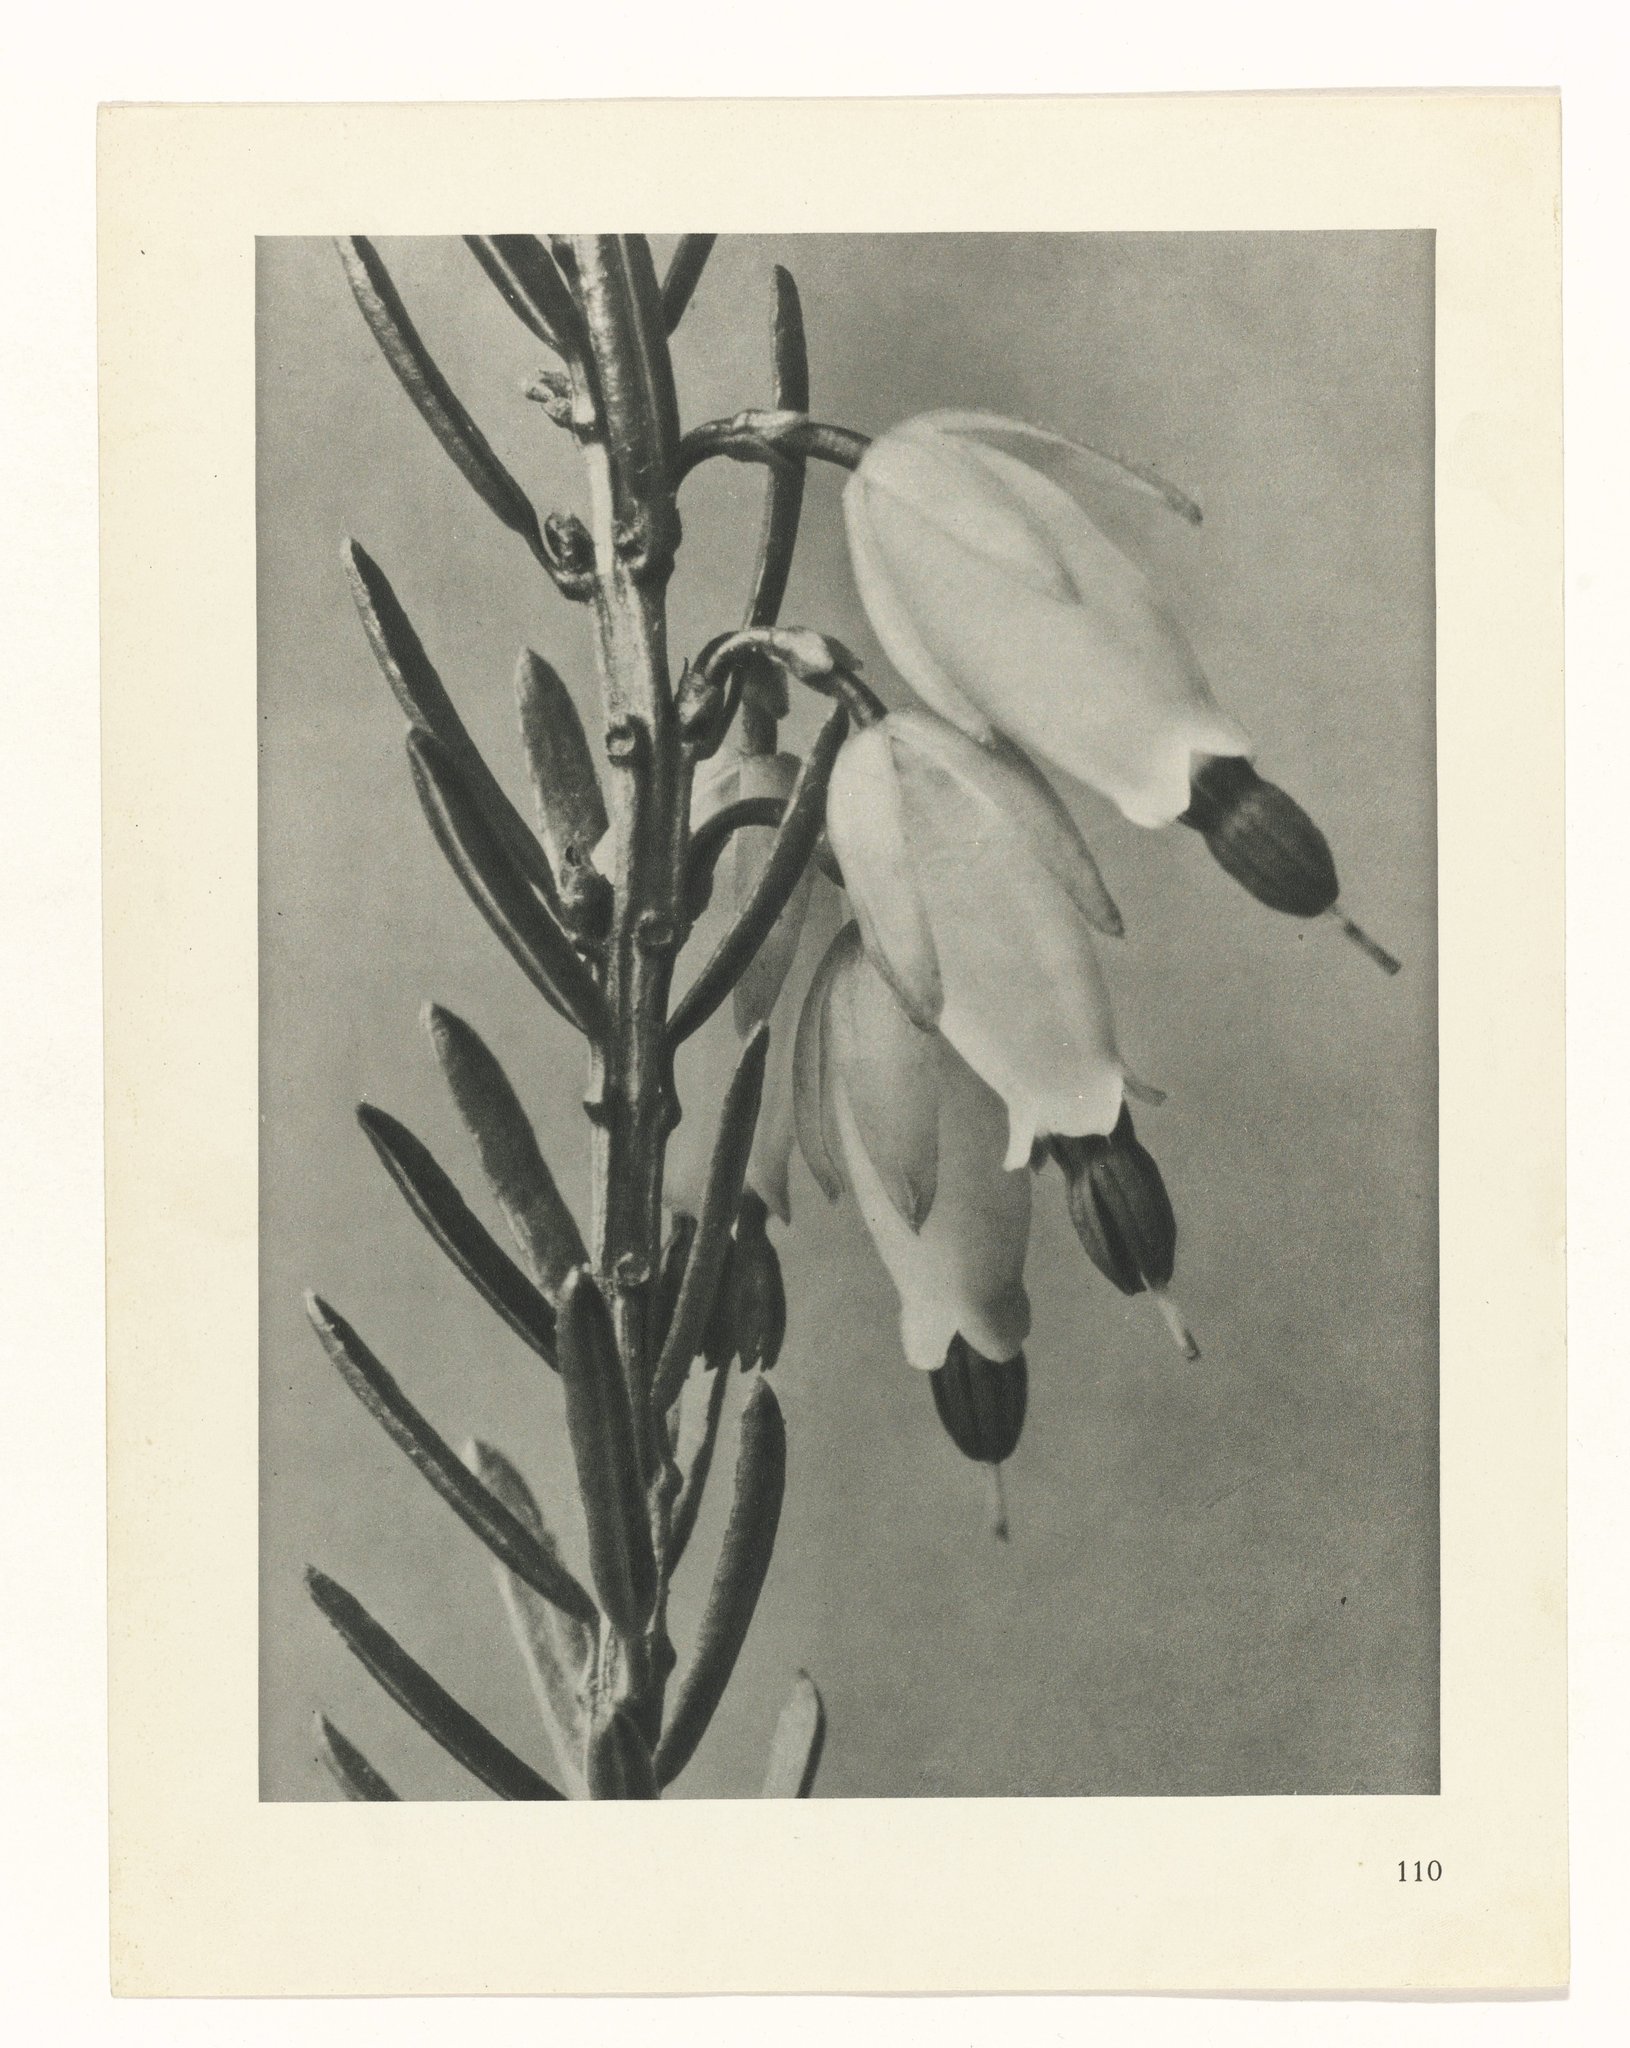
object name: photograph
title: Urformen der Kunst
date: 1928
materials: ink, paper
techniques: rotogravure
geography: berlin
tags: plants (in general)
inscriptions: number: ‘110’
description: facher Vergrößerung. Afkomstig uit losbladige uitgave.